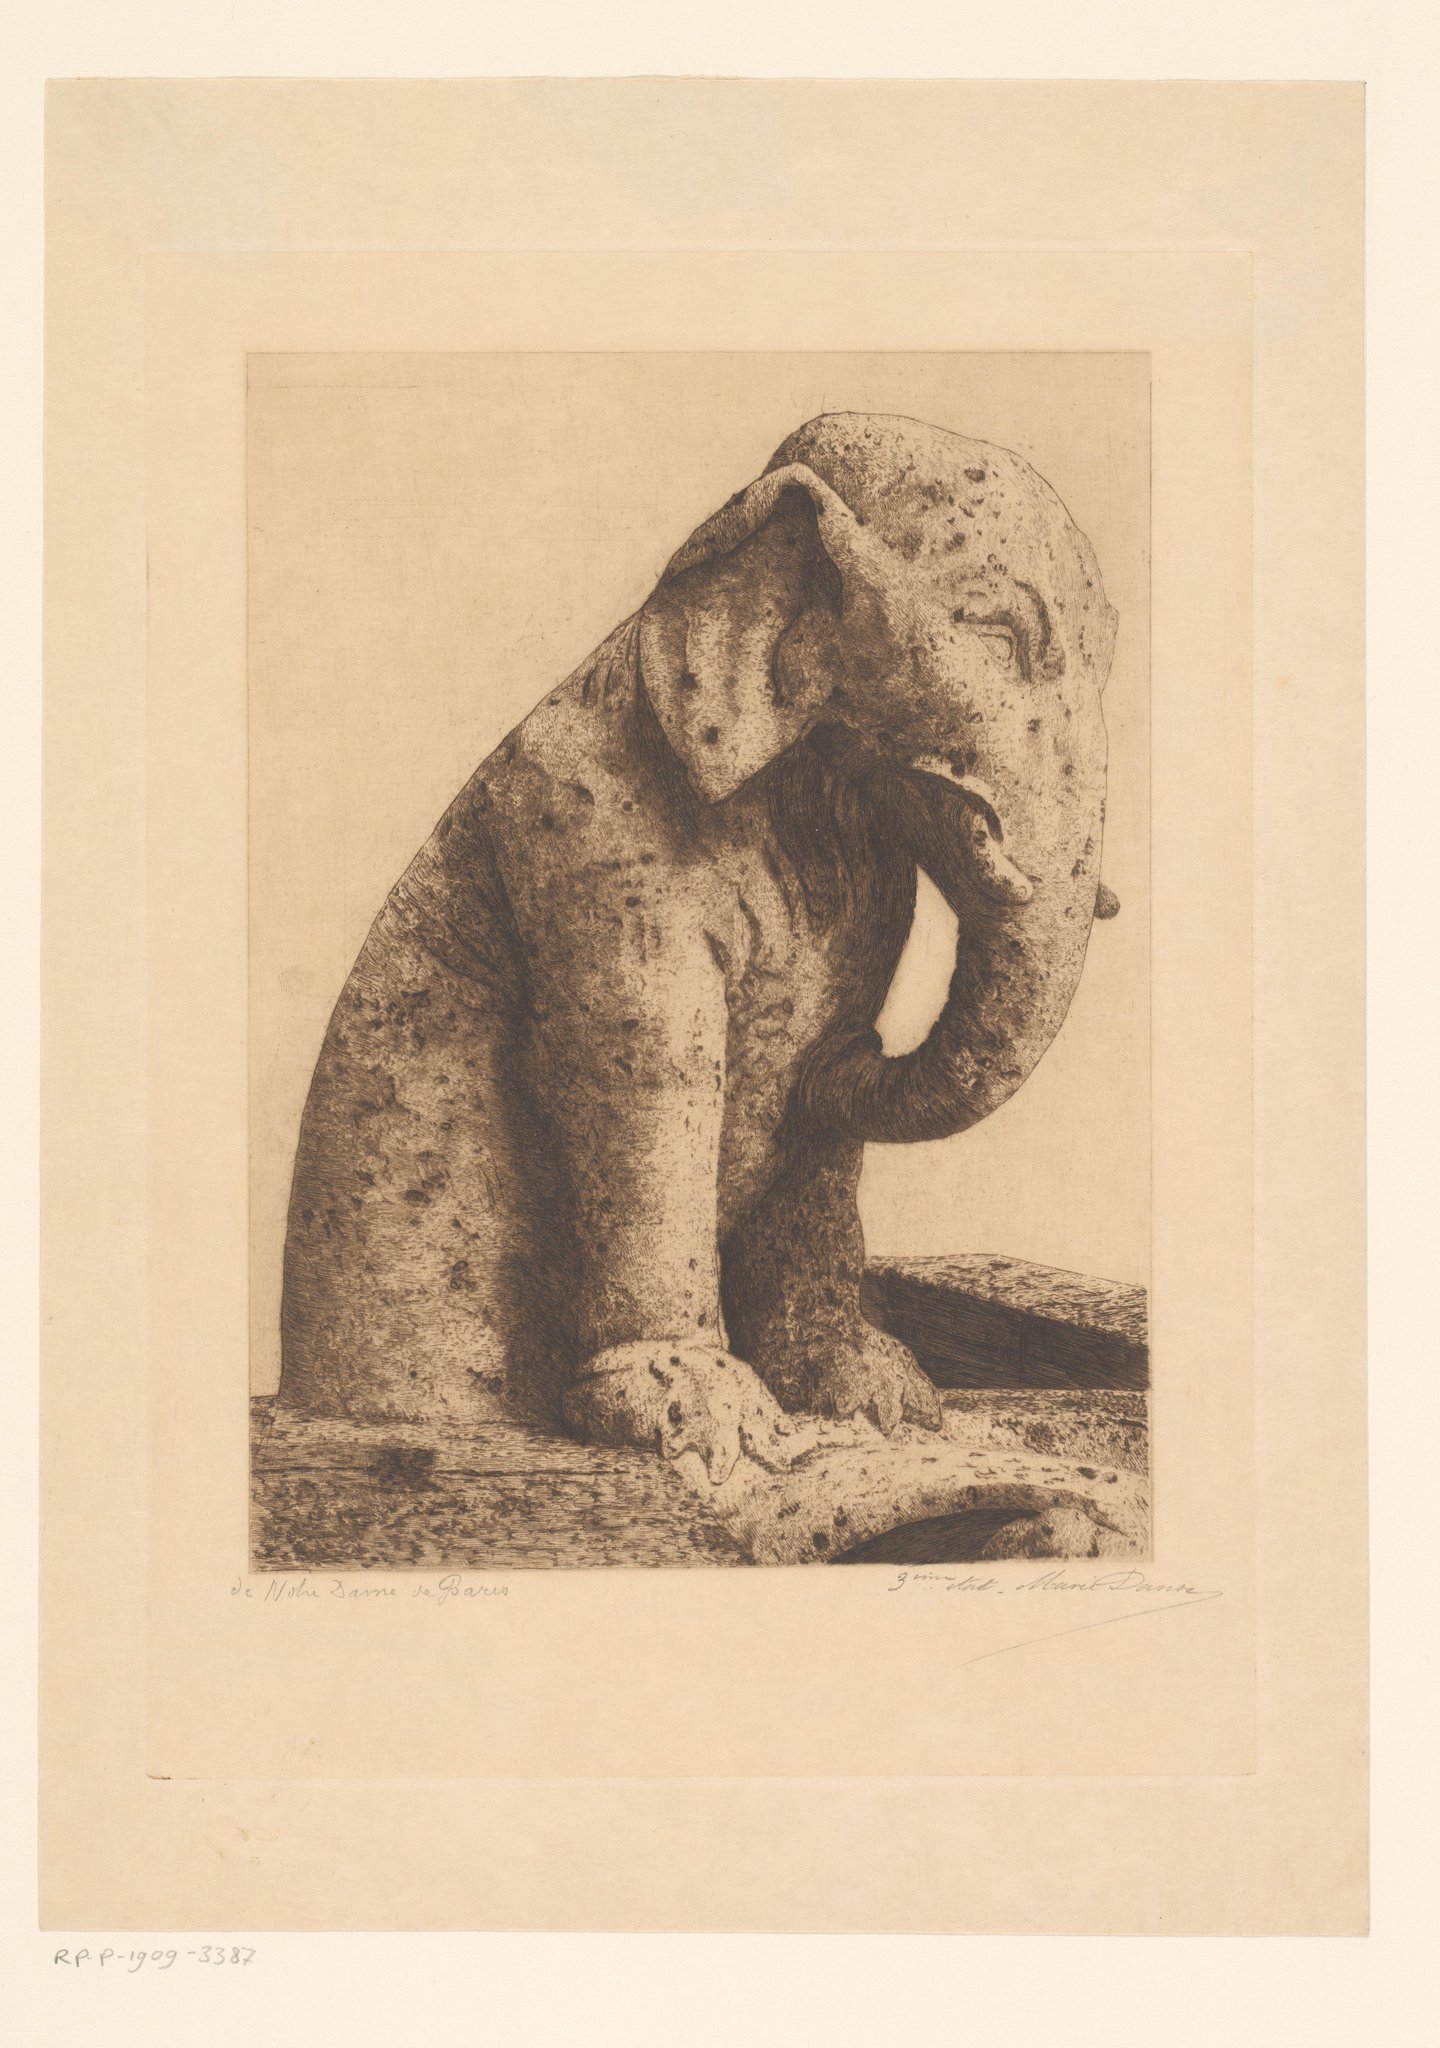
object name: print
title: Waterspuwer van de Notre-Dame te Parijs in de vorm van een olifant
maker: marie danse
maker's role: print maker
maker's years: 1867-1942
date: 1877-1909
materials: paper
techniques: etching, intaglio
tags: piece of sculpture, reproduction of a piece of sculpture, trunked animals: elephant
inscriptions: inscription: ‘De Notre Dame de Paris; 3em etat’, collector's mark: Lugt 2228